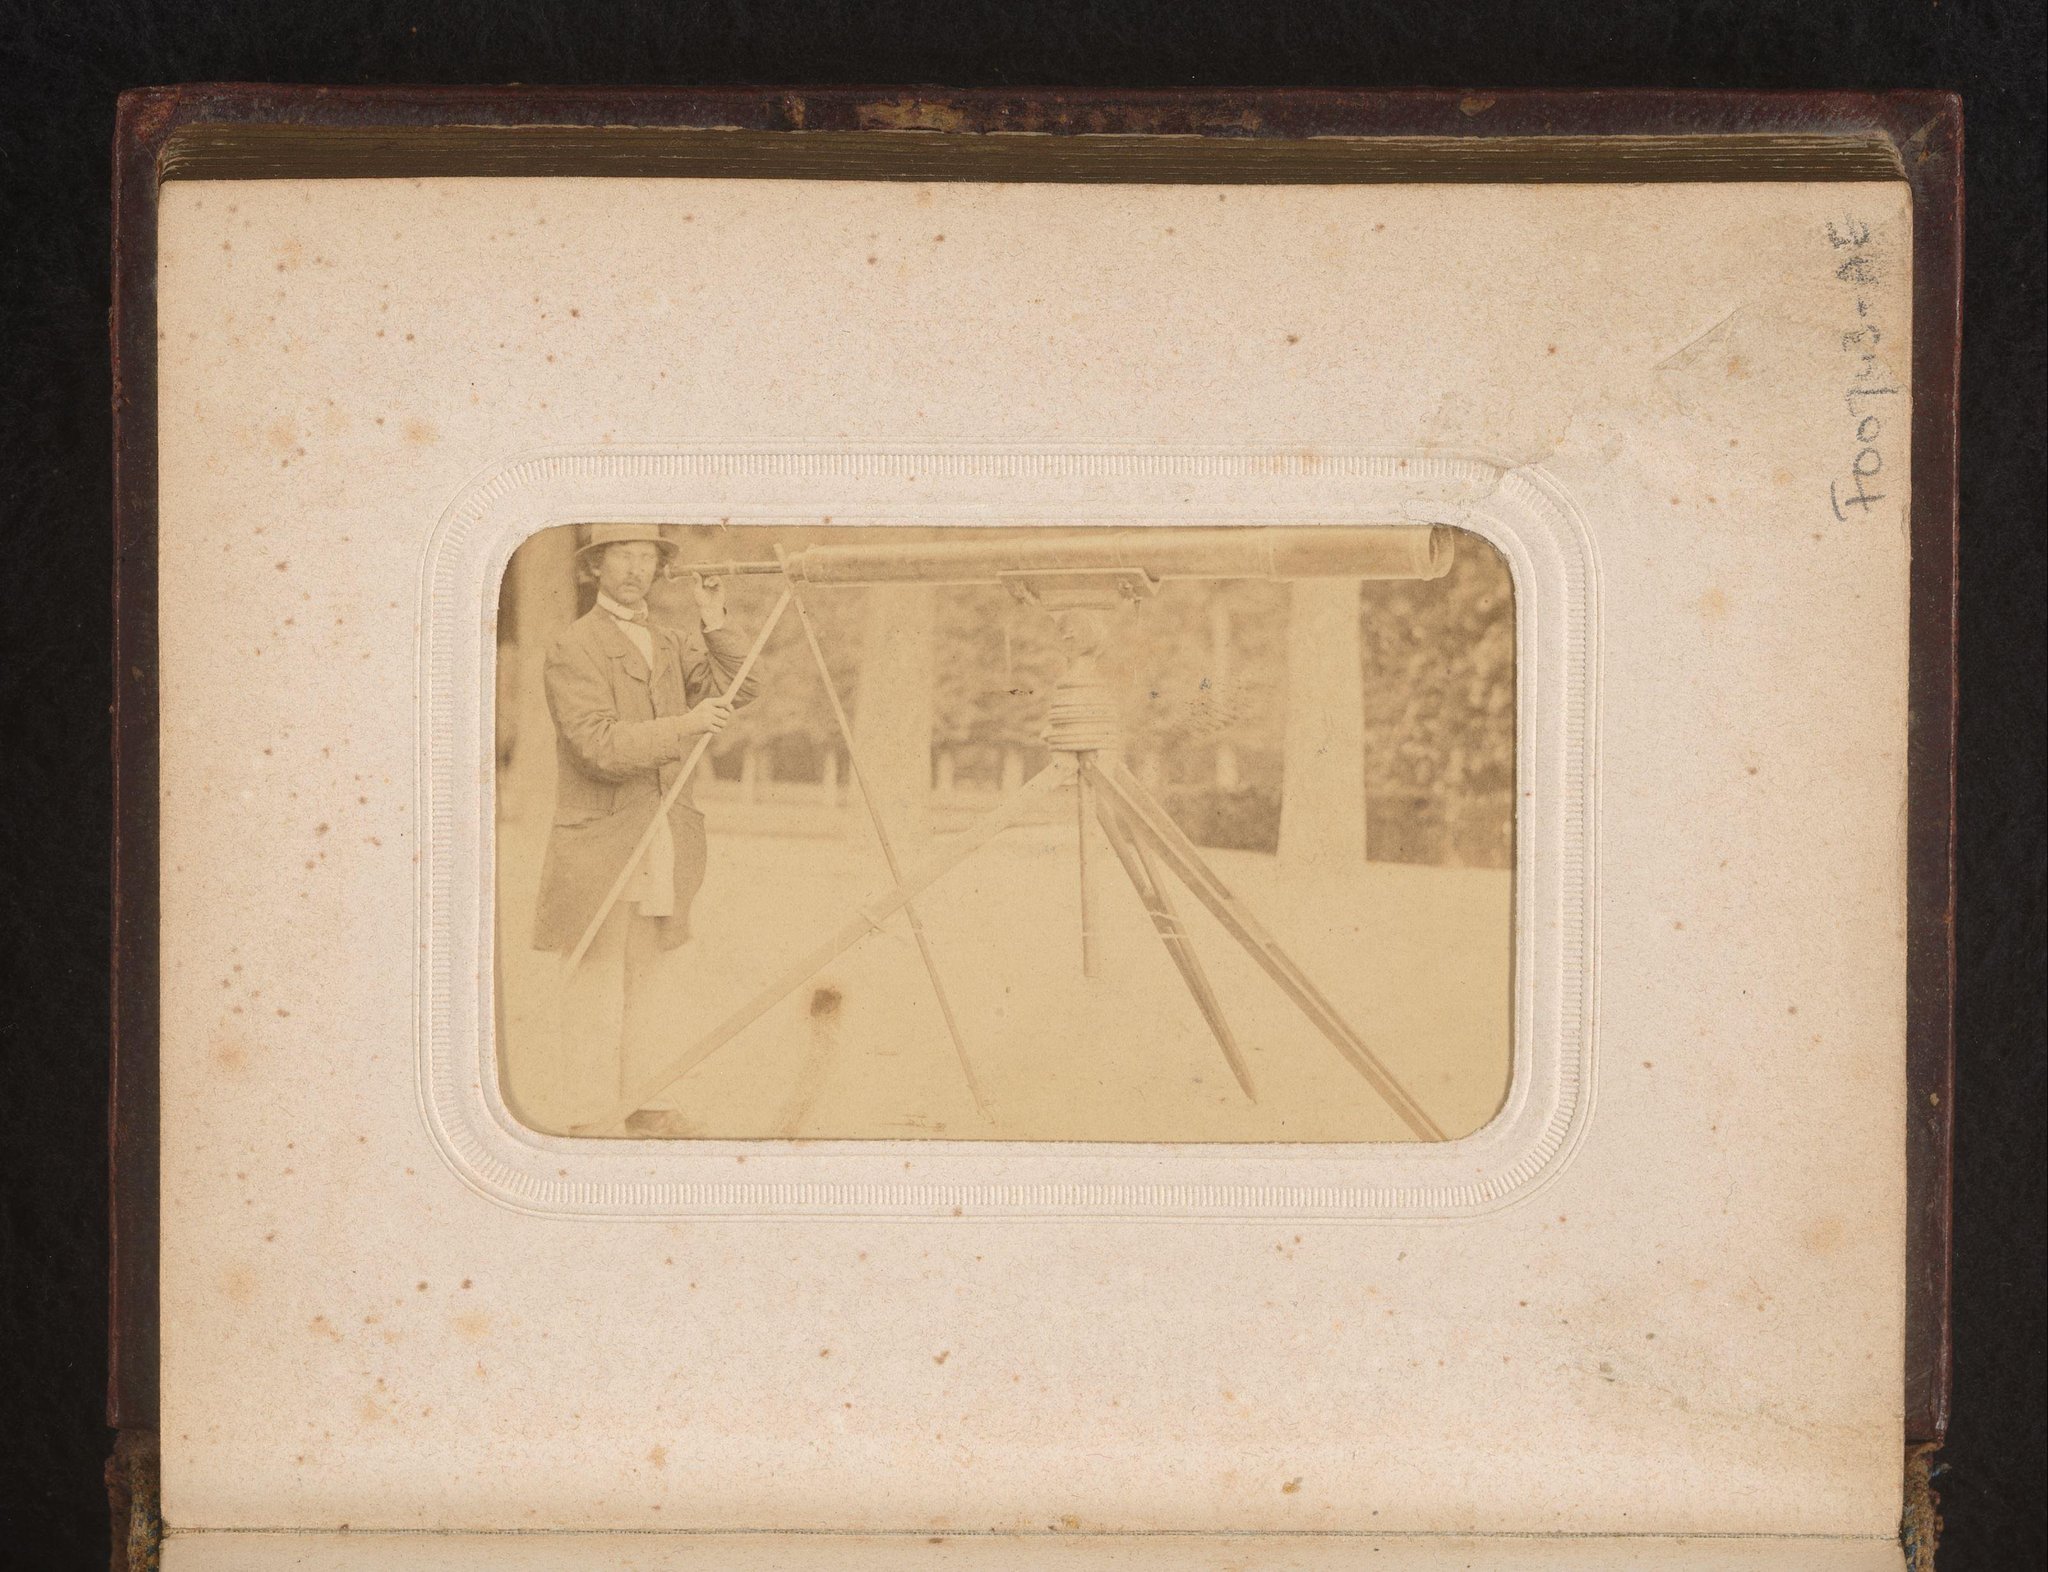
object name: photograph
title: Man met een telescoop op statief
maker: lesueur (fotograaf)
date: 1860-1900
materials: cardboard, photographic support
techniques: albumen print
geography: france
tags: adult man, telescope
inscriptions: inscription: ‘LESUEUR/ PHOTOGRAPHE/ PASSAGE du CHEMIN de FER/ à St. GERMAIN-EN-LAYE’